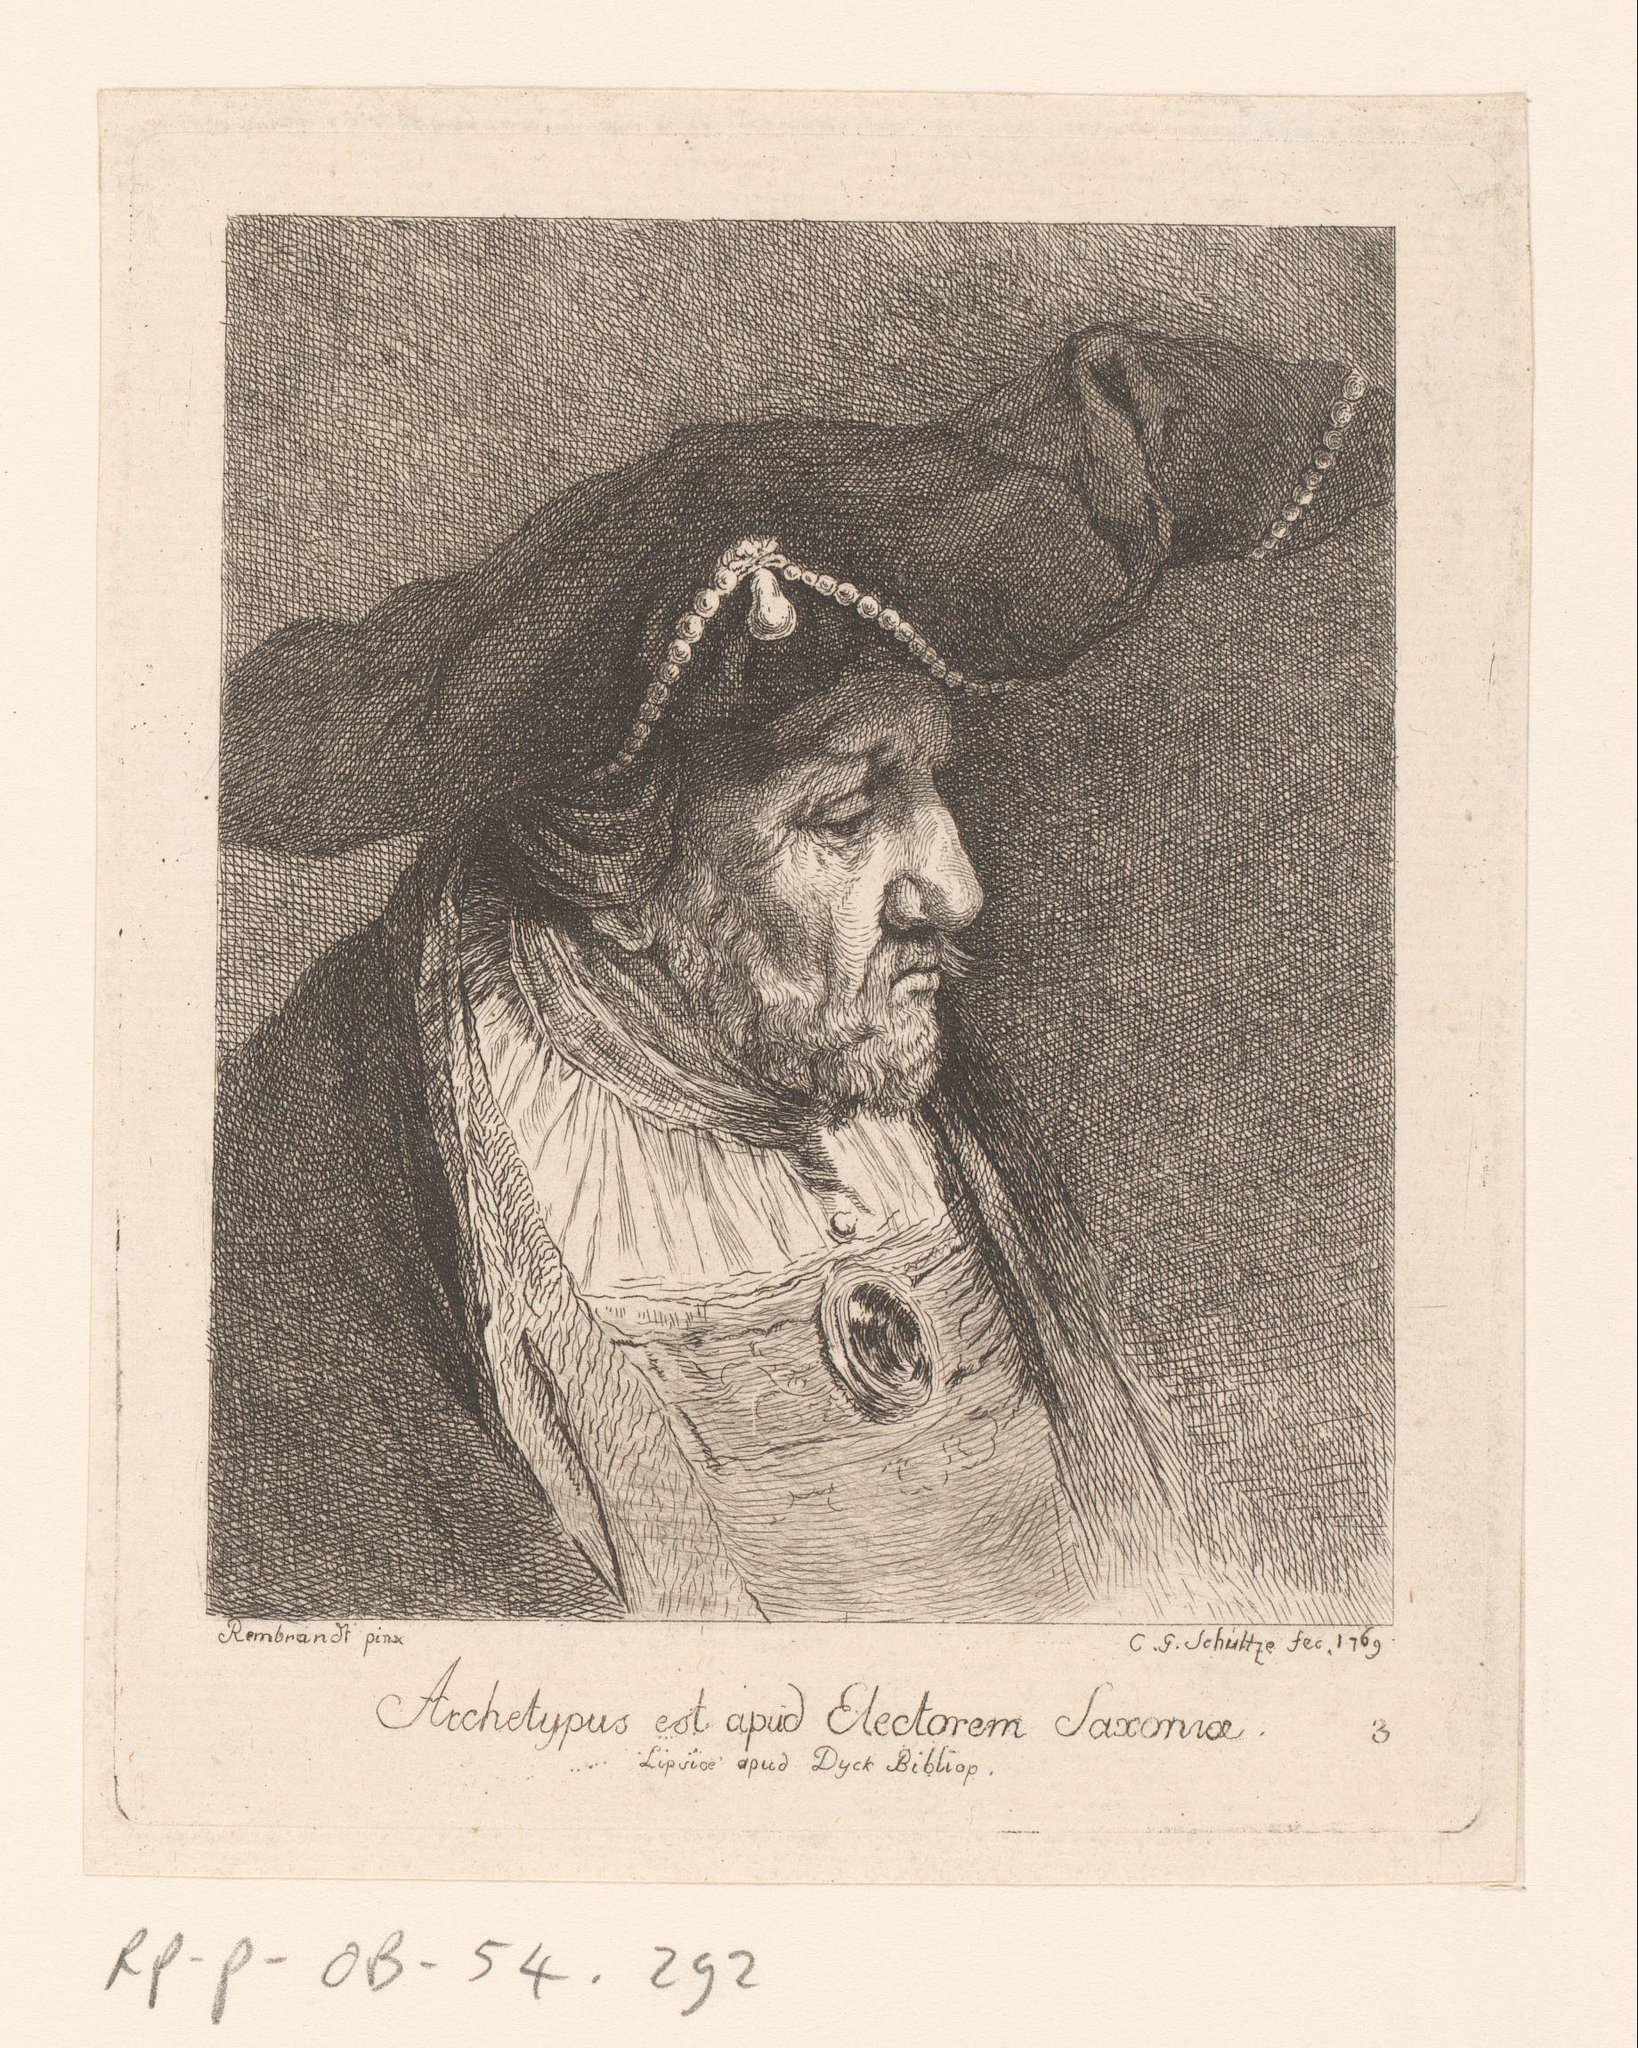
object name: print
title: Man met baret met rij parels afgezet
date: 1769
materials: paper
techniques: etching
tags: old man, pearl; pearl necklace, head-gear: beret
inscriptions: collector's mark: Lugt 240